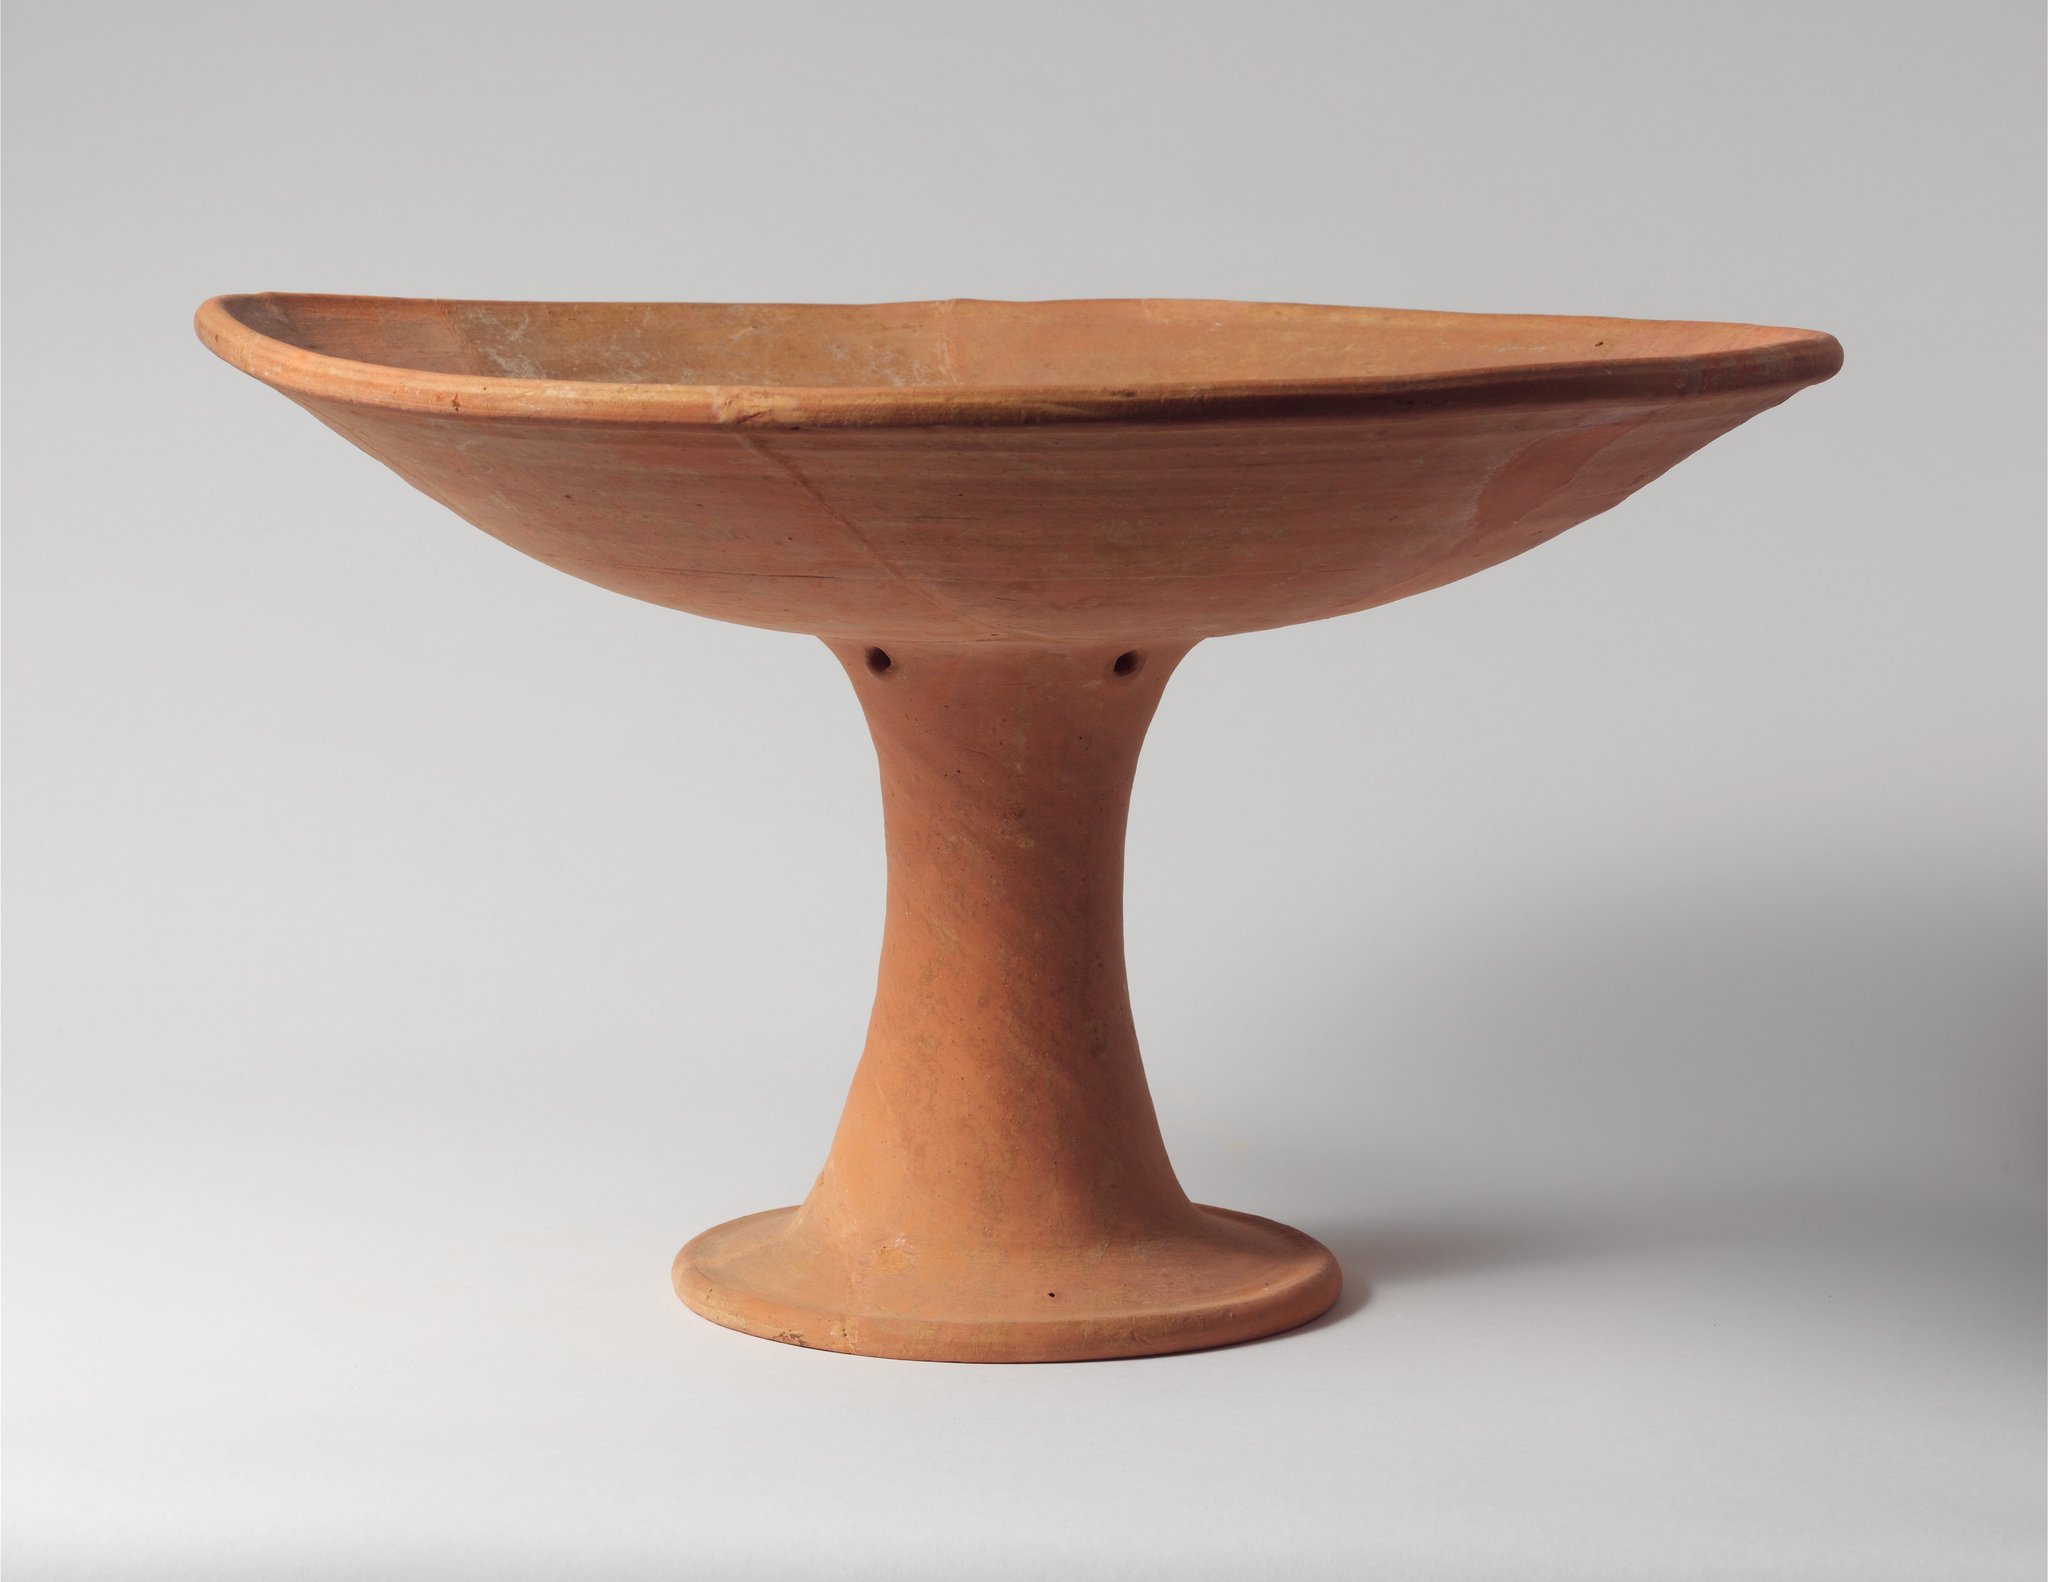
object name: stemmed dish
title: Terracotta stemmed dish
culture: lydian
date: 600-501 BCE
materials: terracotta